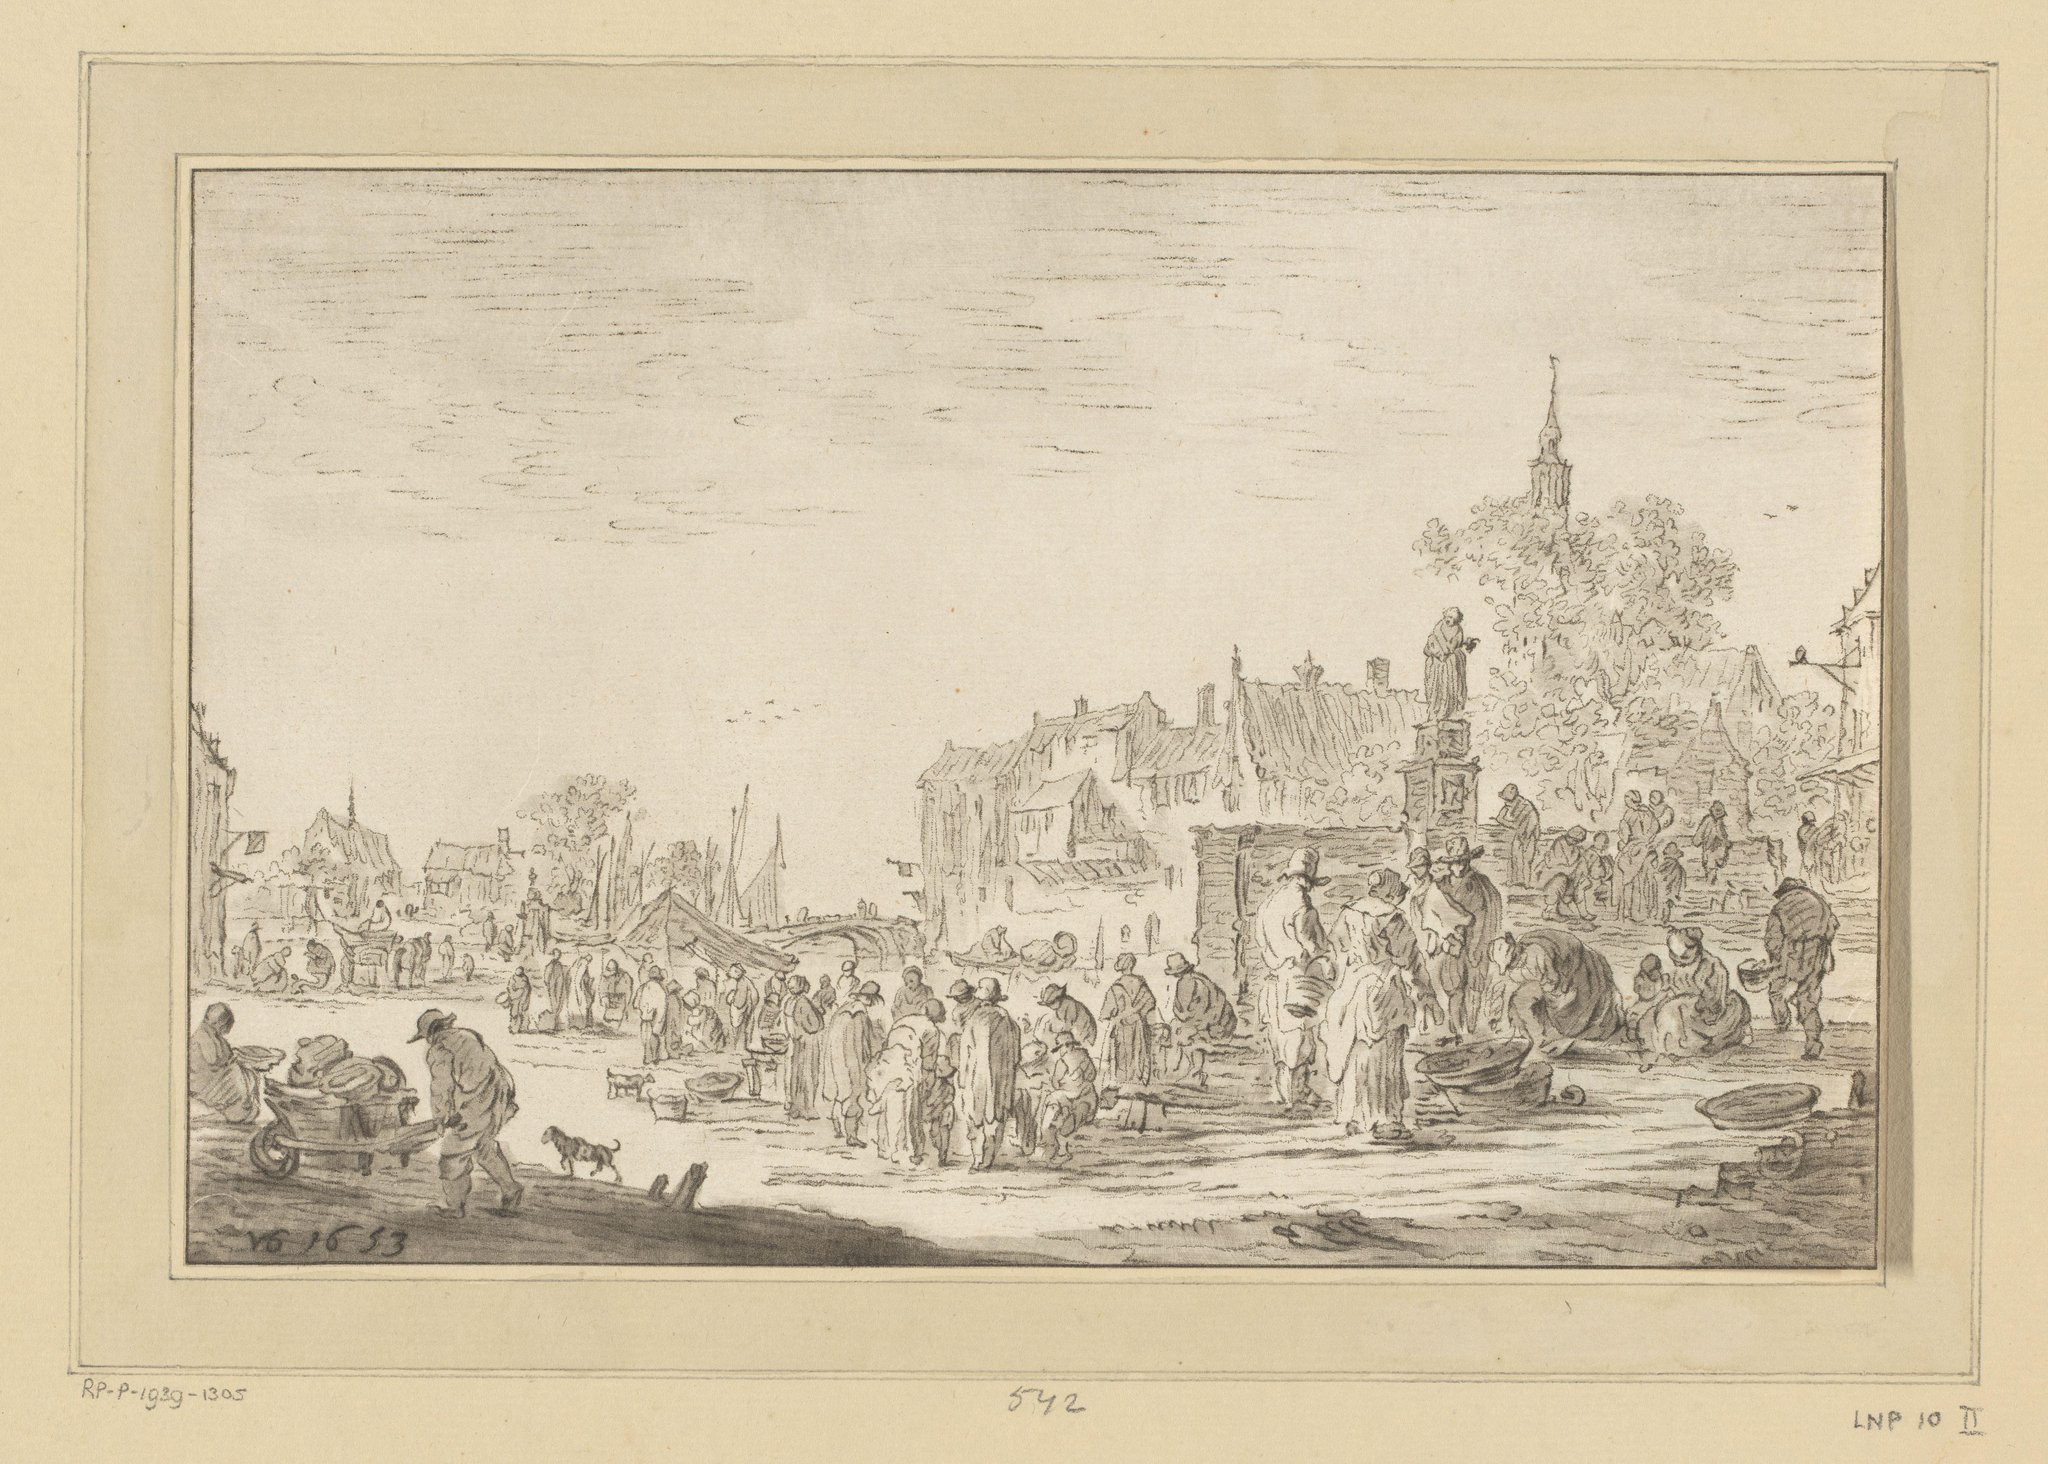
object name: print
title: Vismarkt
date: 1767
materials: paper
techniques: printmaking, etching, roulette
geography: amsterdam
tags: market, commercial fishery (+ trade ~ crafts, industries, agriculture)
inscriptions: collector's mark: ‘RIJKS / MUSM’, inscription: ‘Jan Josephzoon van Goyen. del. Ploos van Amstel. Fecit. 1767.’, collector's mark: Lugt 2725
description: Bij het water in een stad komen mensen bijeen om vis te kopen en te verkopen. Rechts een standbeeld. De prent ligt los in een album, zie blad 10.